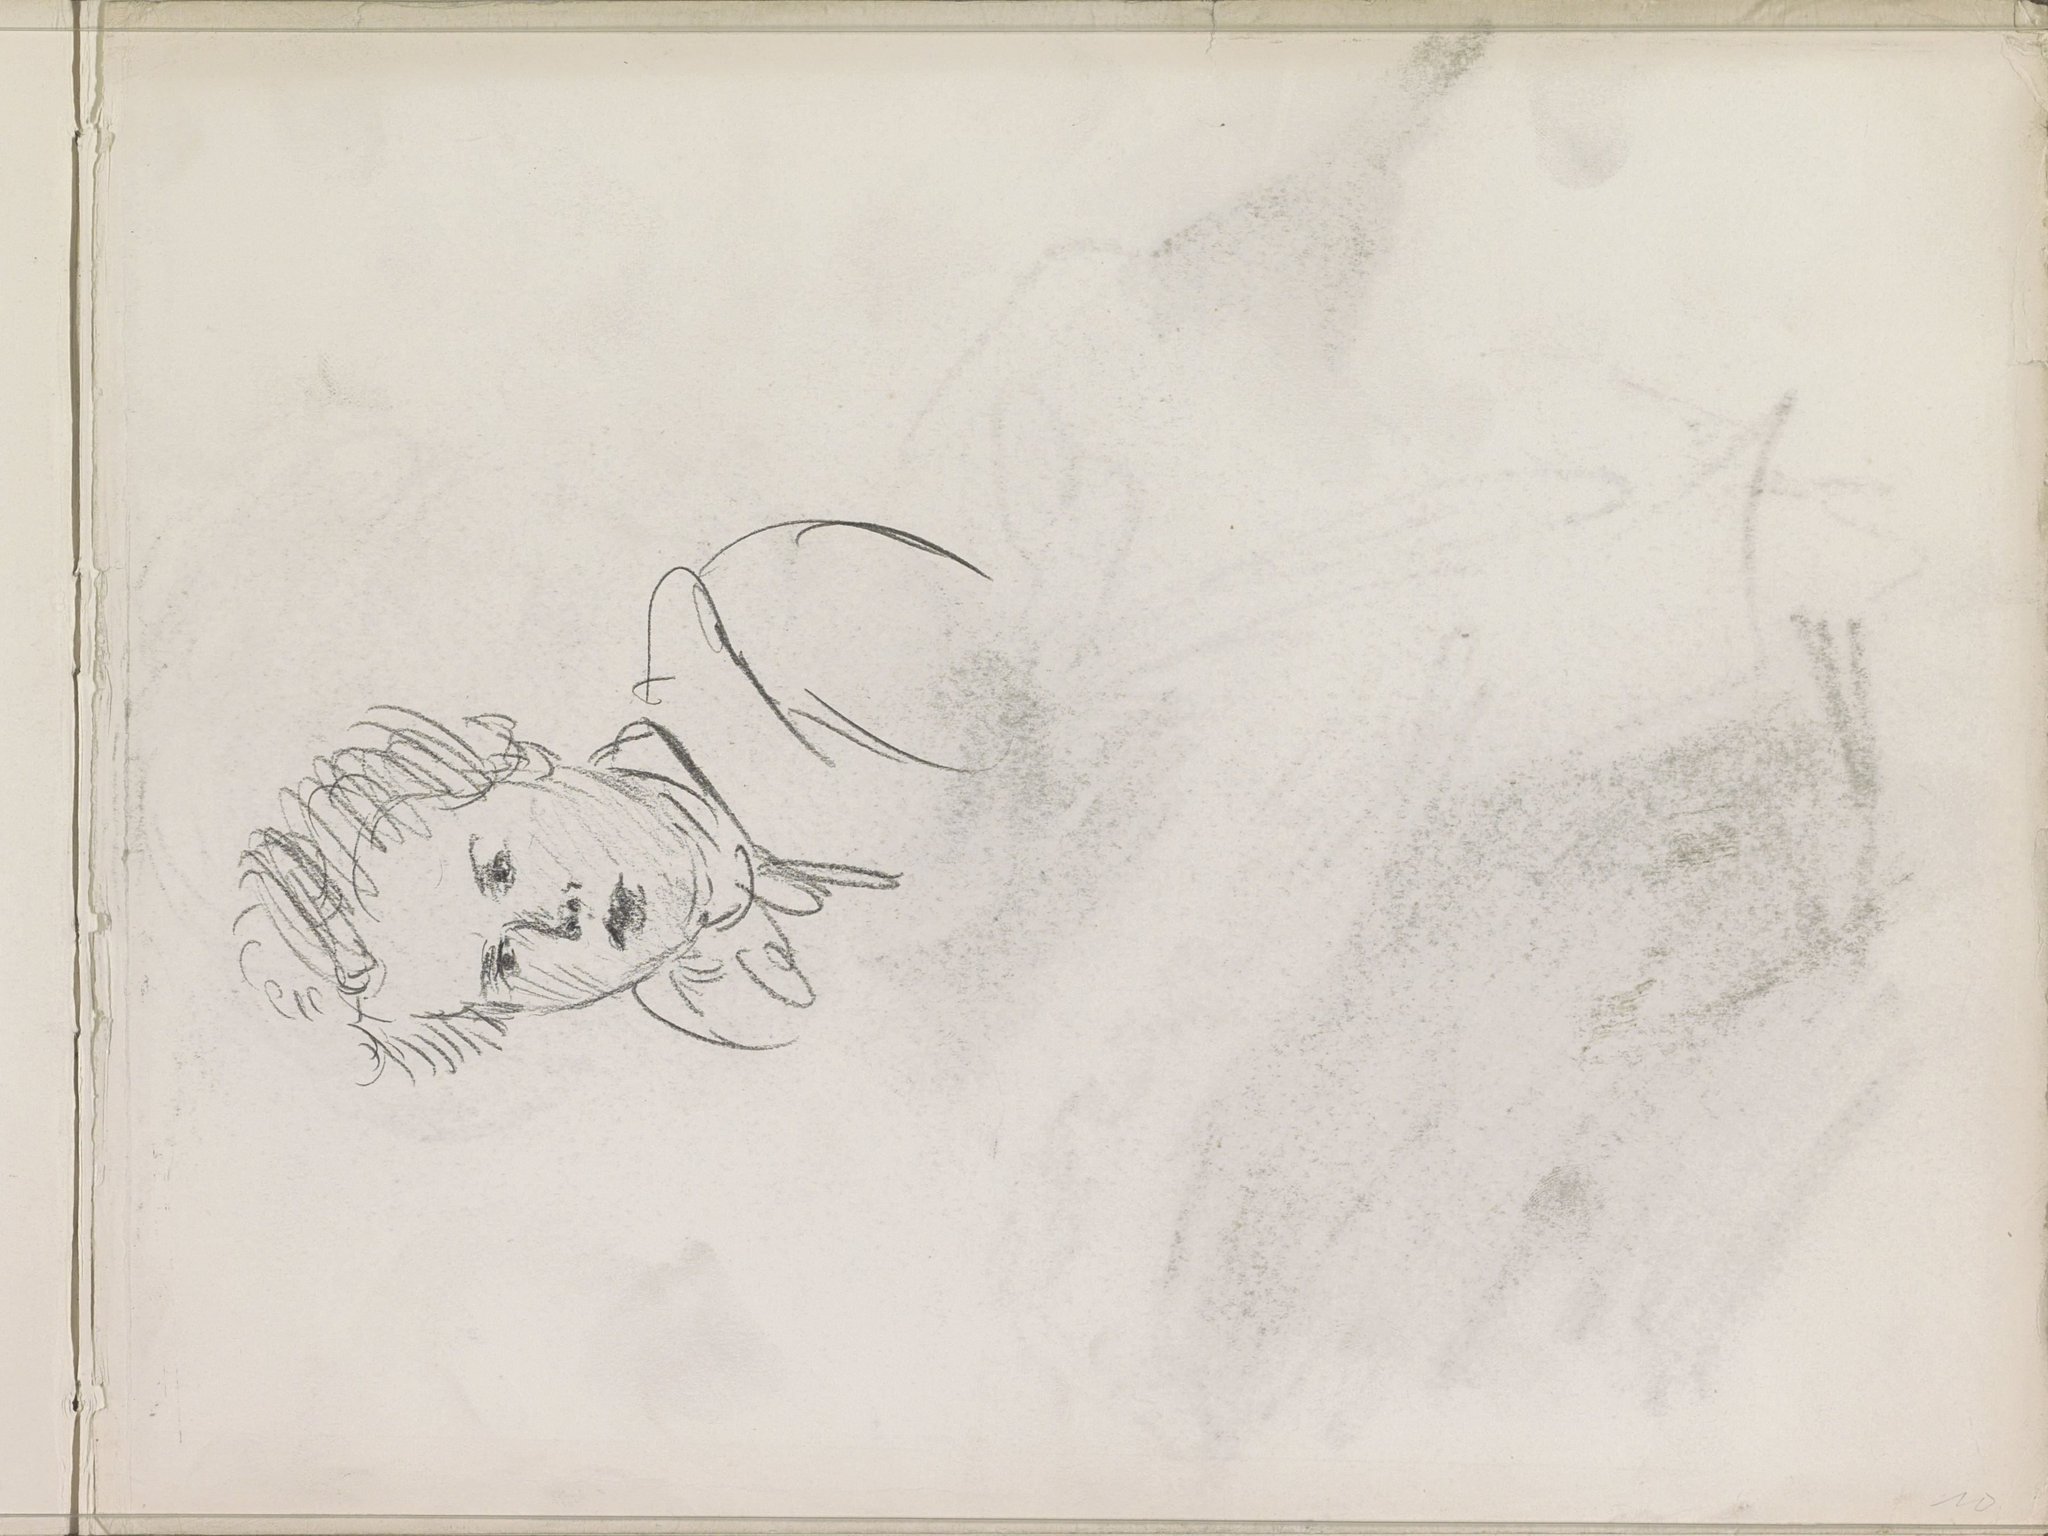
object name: sketchbook leaf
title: Figuurstudie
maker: isaac israels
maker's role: draughtsman, painter, print maker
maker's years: 1865-1934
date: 1875-1934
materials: chalk, paper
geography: the hague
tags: head (human)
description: Blad 10 recto uit schetsboek VII met 26 bladen.